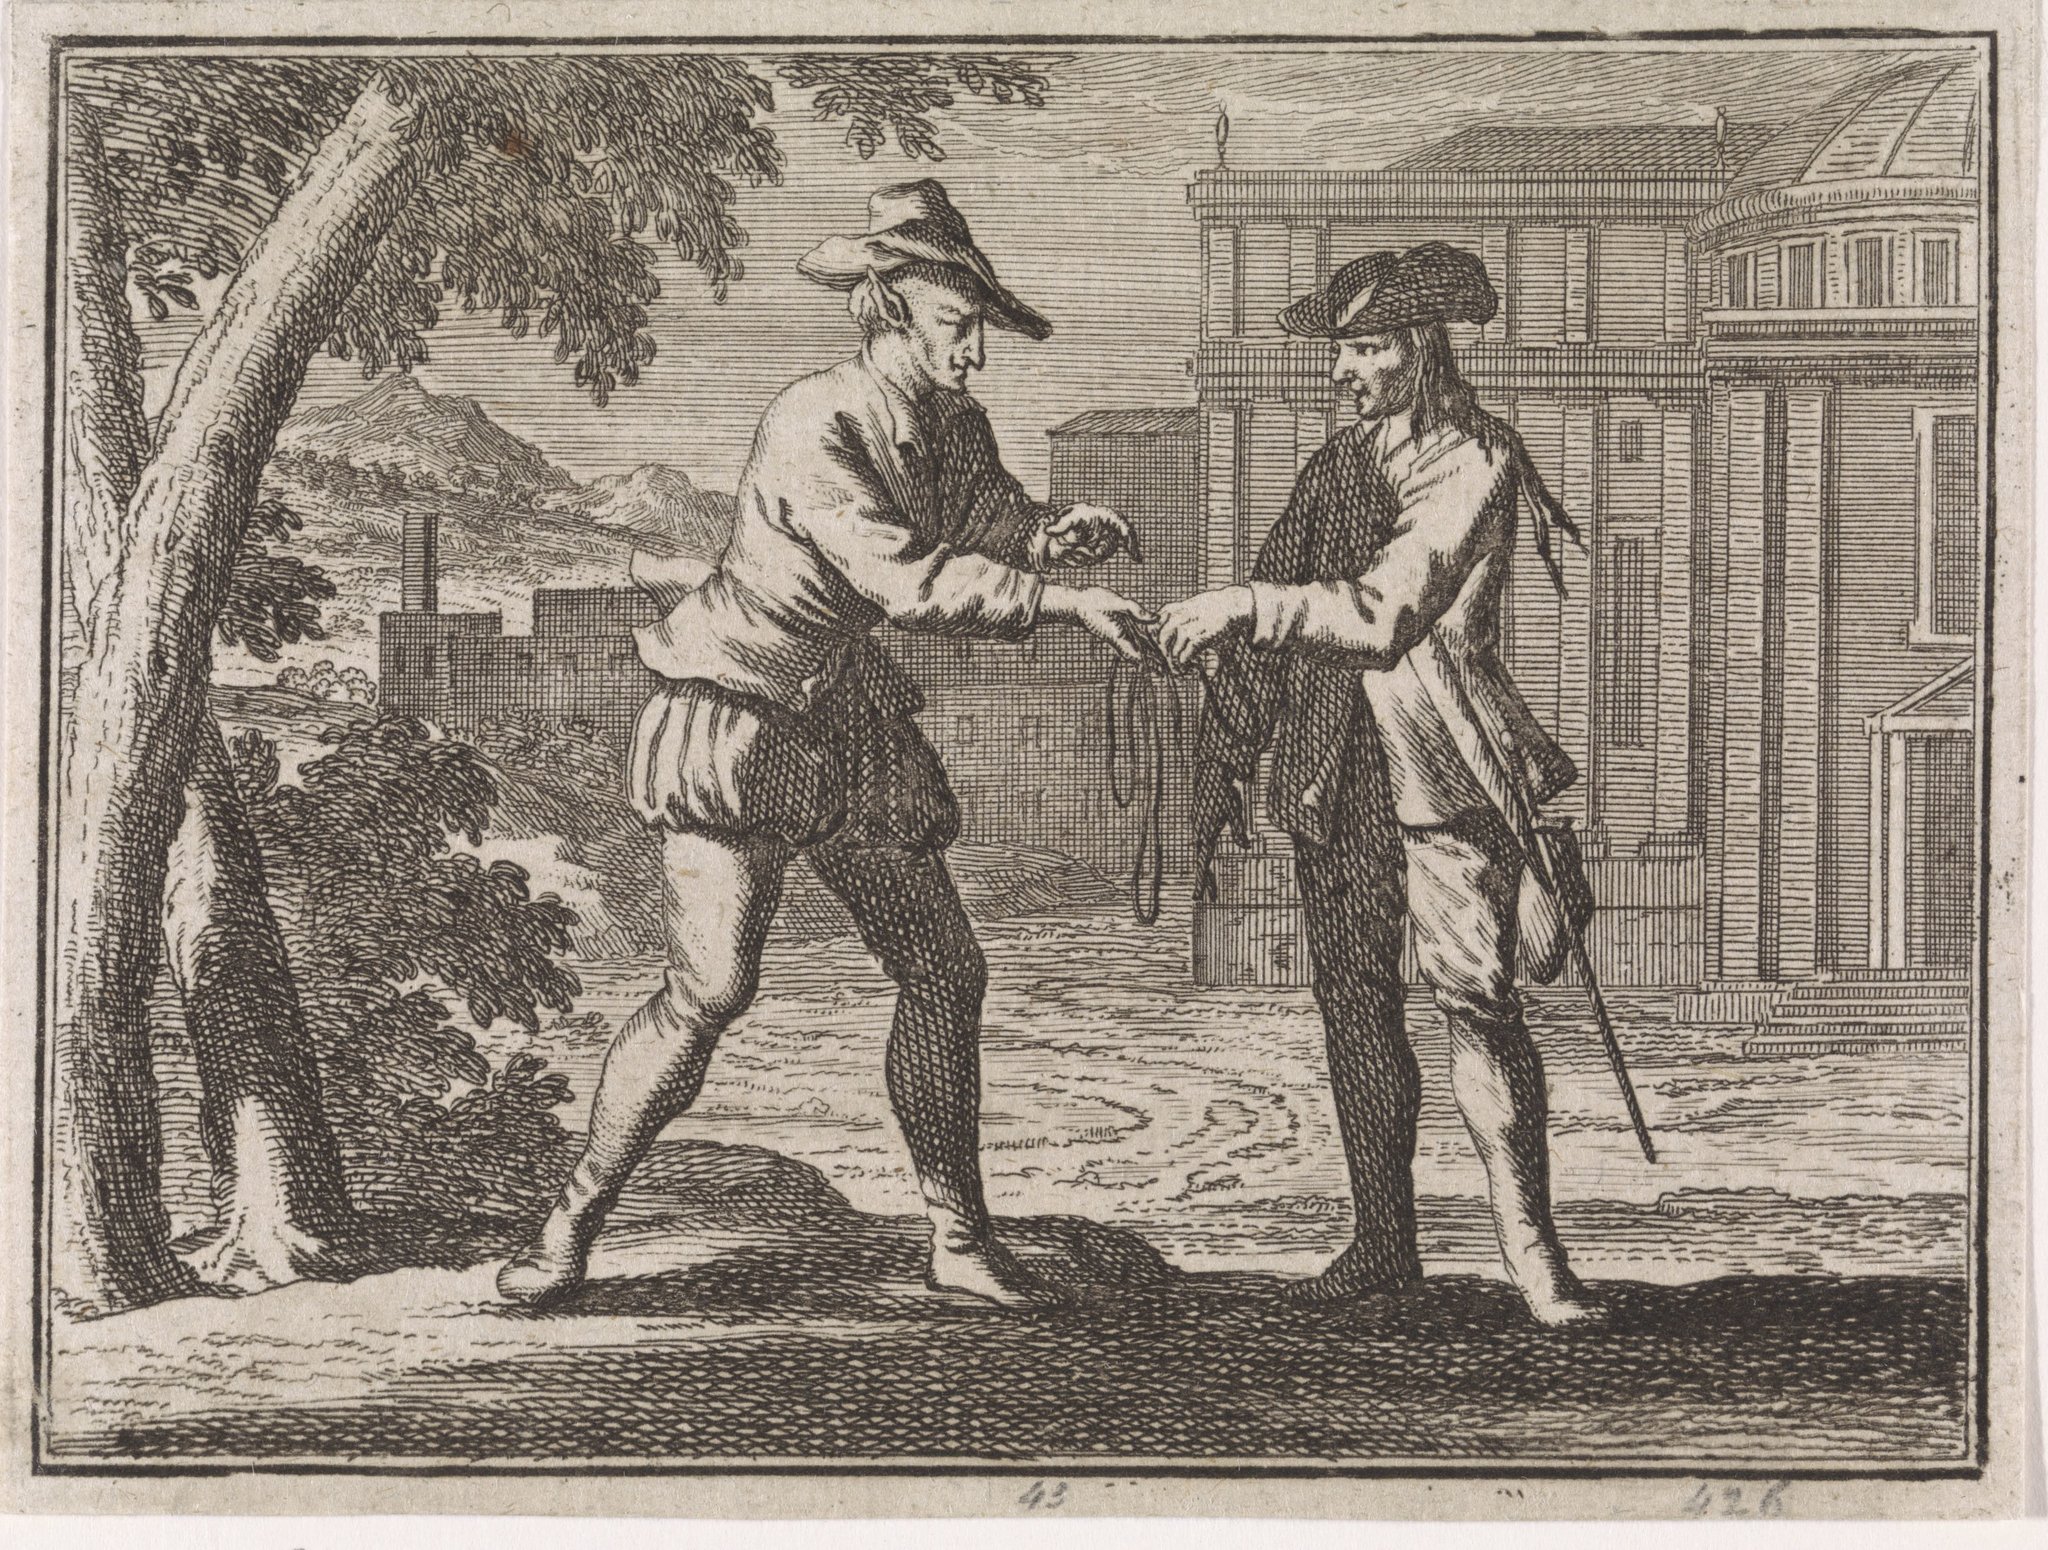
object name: book illustration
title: Was hören ? wie hören ? Wann hören ?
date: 1704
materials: paper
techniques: etching, letterpress printing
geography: nuremberg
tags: devil(s) appearing to mortals, trying to seduce them; temptation, suicide out of despair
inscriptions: collector's mark: Lugt 2228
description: Illustratie uit: Abraham a Sancta Clara. Heilsames Gemisch Gemasch, das ist: Allerley seltsame und verwunderliche Geschichten (...). Neurenberg: Christoph Weigel, 1704, p. 426.